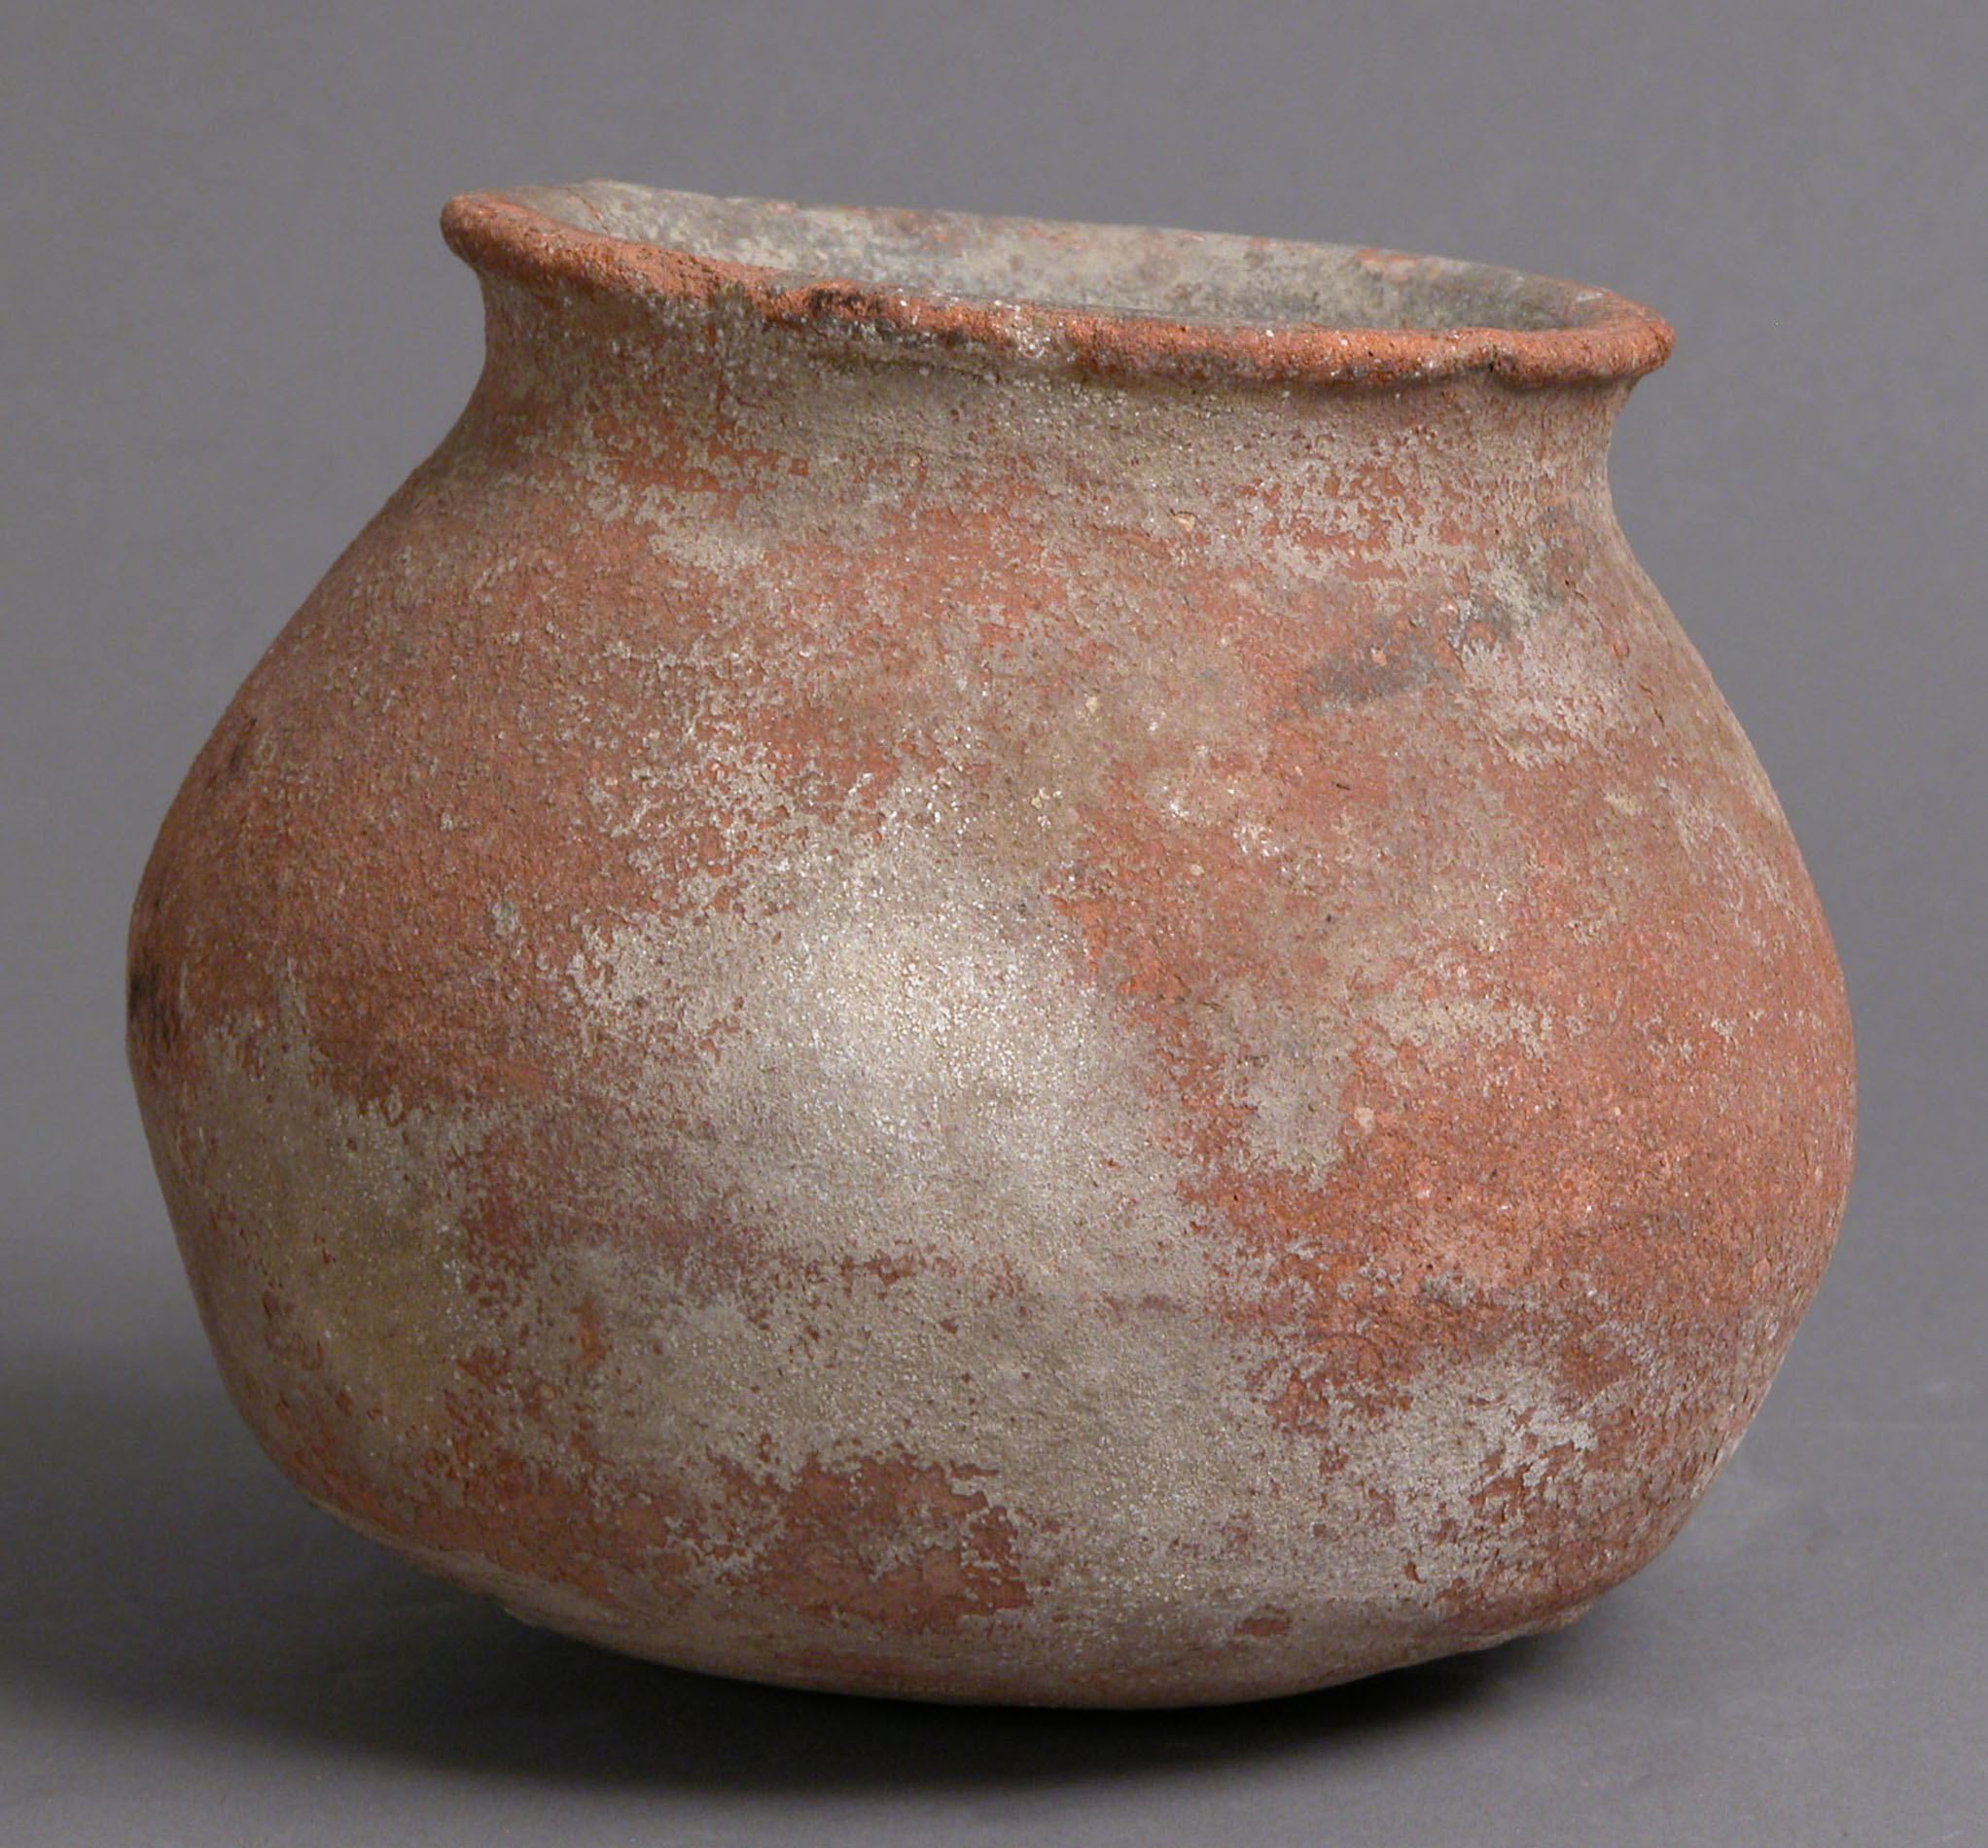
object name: pot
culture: coptic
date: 301-700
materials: earthenware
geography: egypt